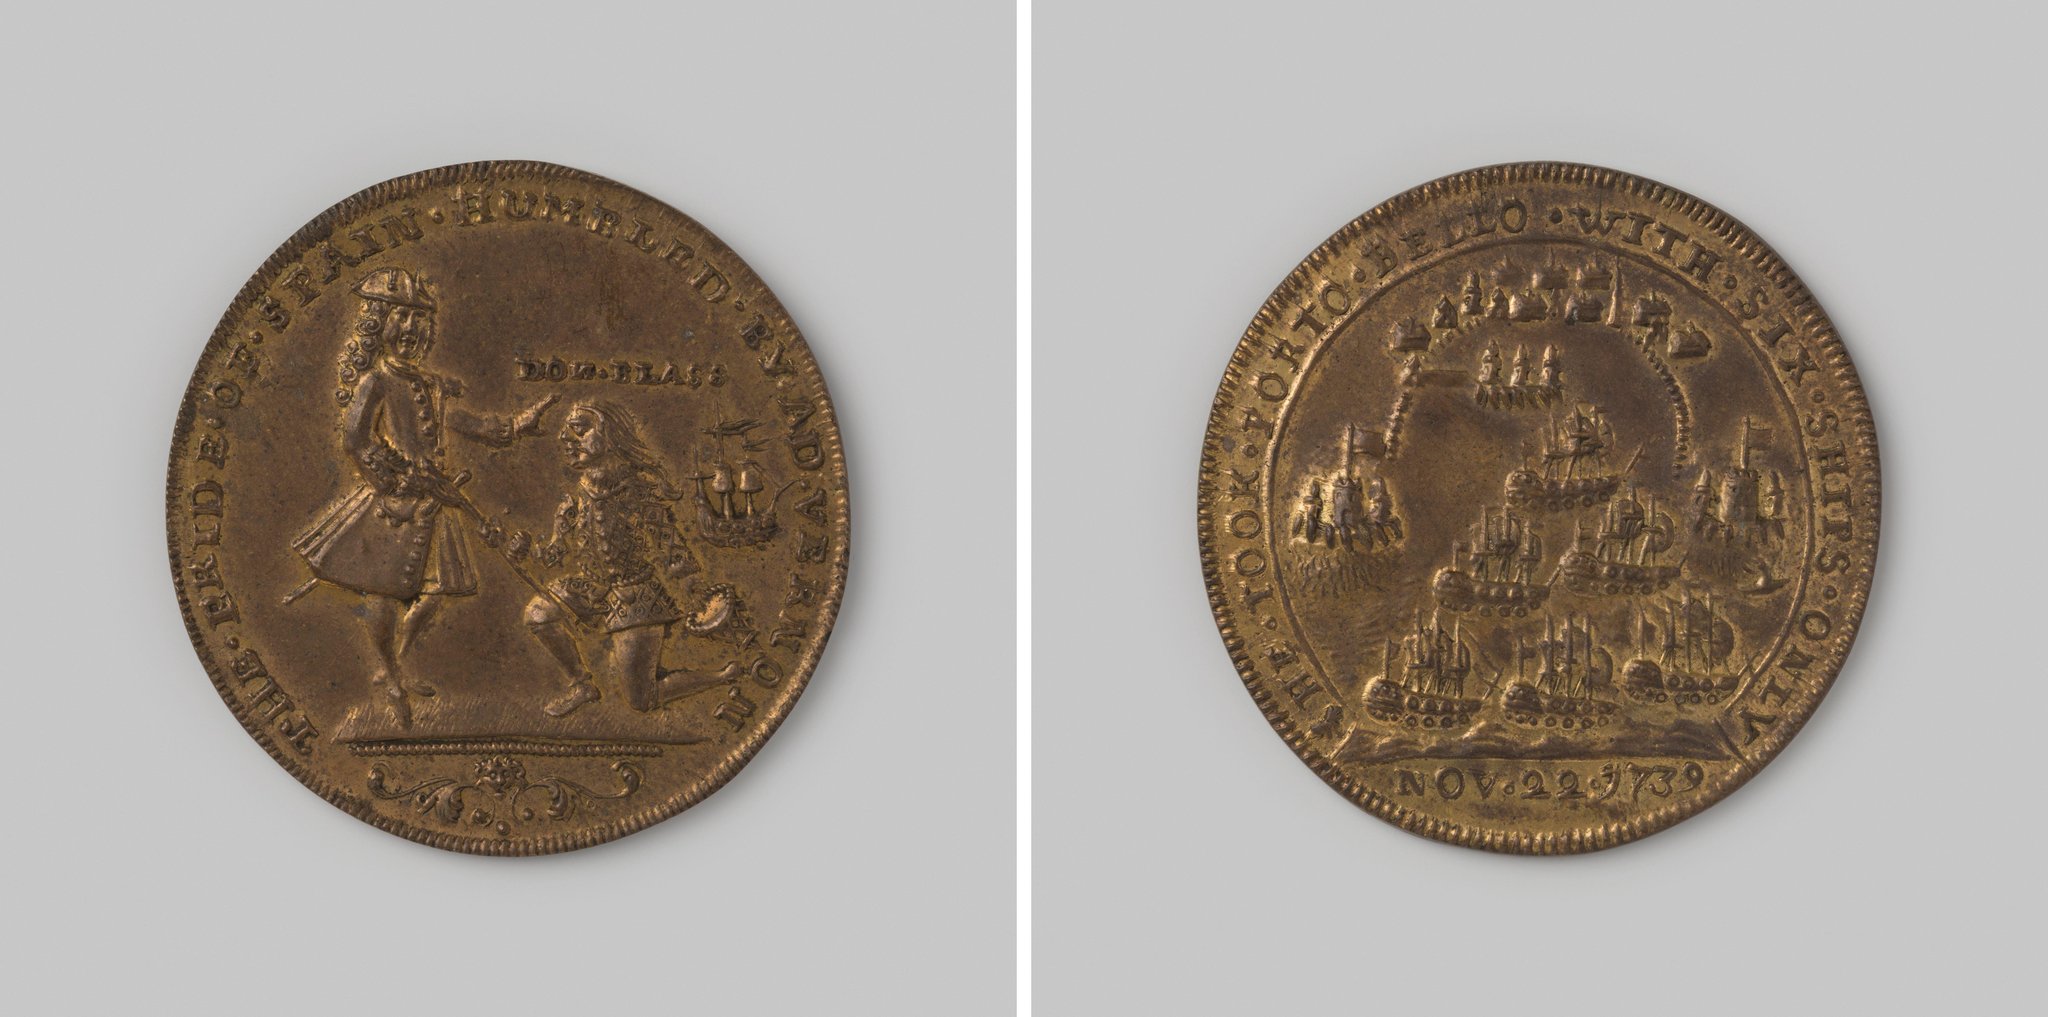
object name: history medal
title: Inname van Porto-Bello door Admiraal Vernon 1739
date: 1739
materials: brass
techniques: striking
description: Verguld messing penning, op de voorzijde Vernon staand naar rechts, ontvangt het zwaard van de Spaanse verdediger Don Blas, rechts een schip, met omschrift, op de keerzijde de haven van Porto Bello waarvoor zes schepen, met omschrift en afsnedetekst.